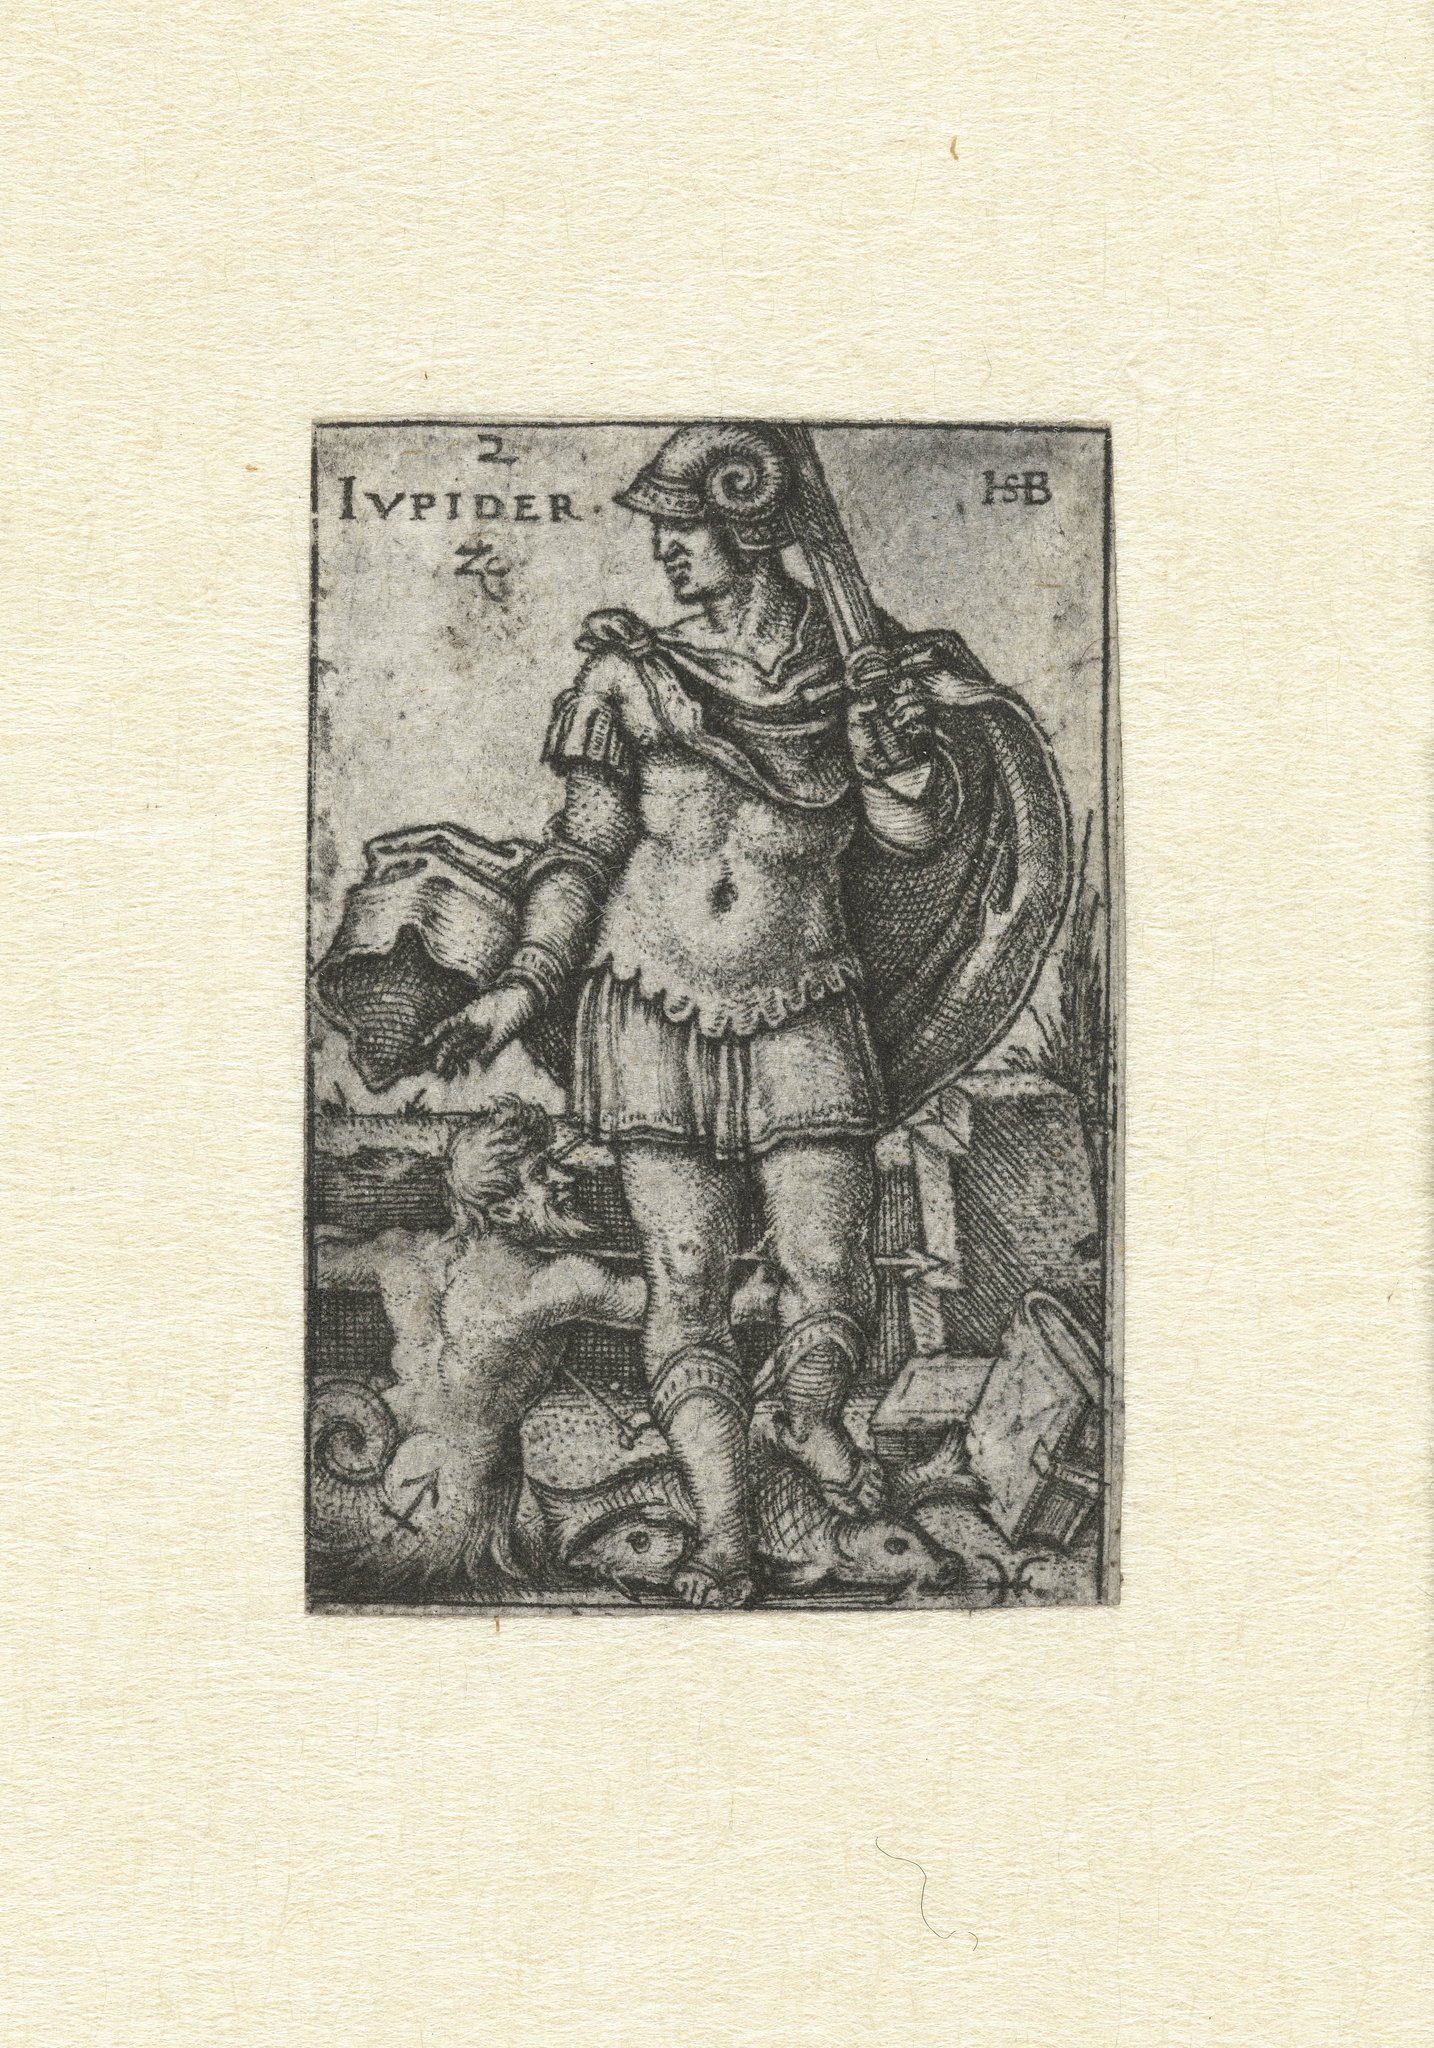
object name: print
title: Ivpider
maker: hans sebald beham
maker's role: designer, draughtsman, print maker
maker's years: 1500-1550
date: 1539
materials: paper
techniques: engraving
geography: frankfurt am main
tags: pisces (zodiacal sign of february), sagittarius (zodiacal sign of november), jupiter (planet)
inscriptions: collector's mark: ‘Hinloopen’ Lugt 11